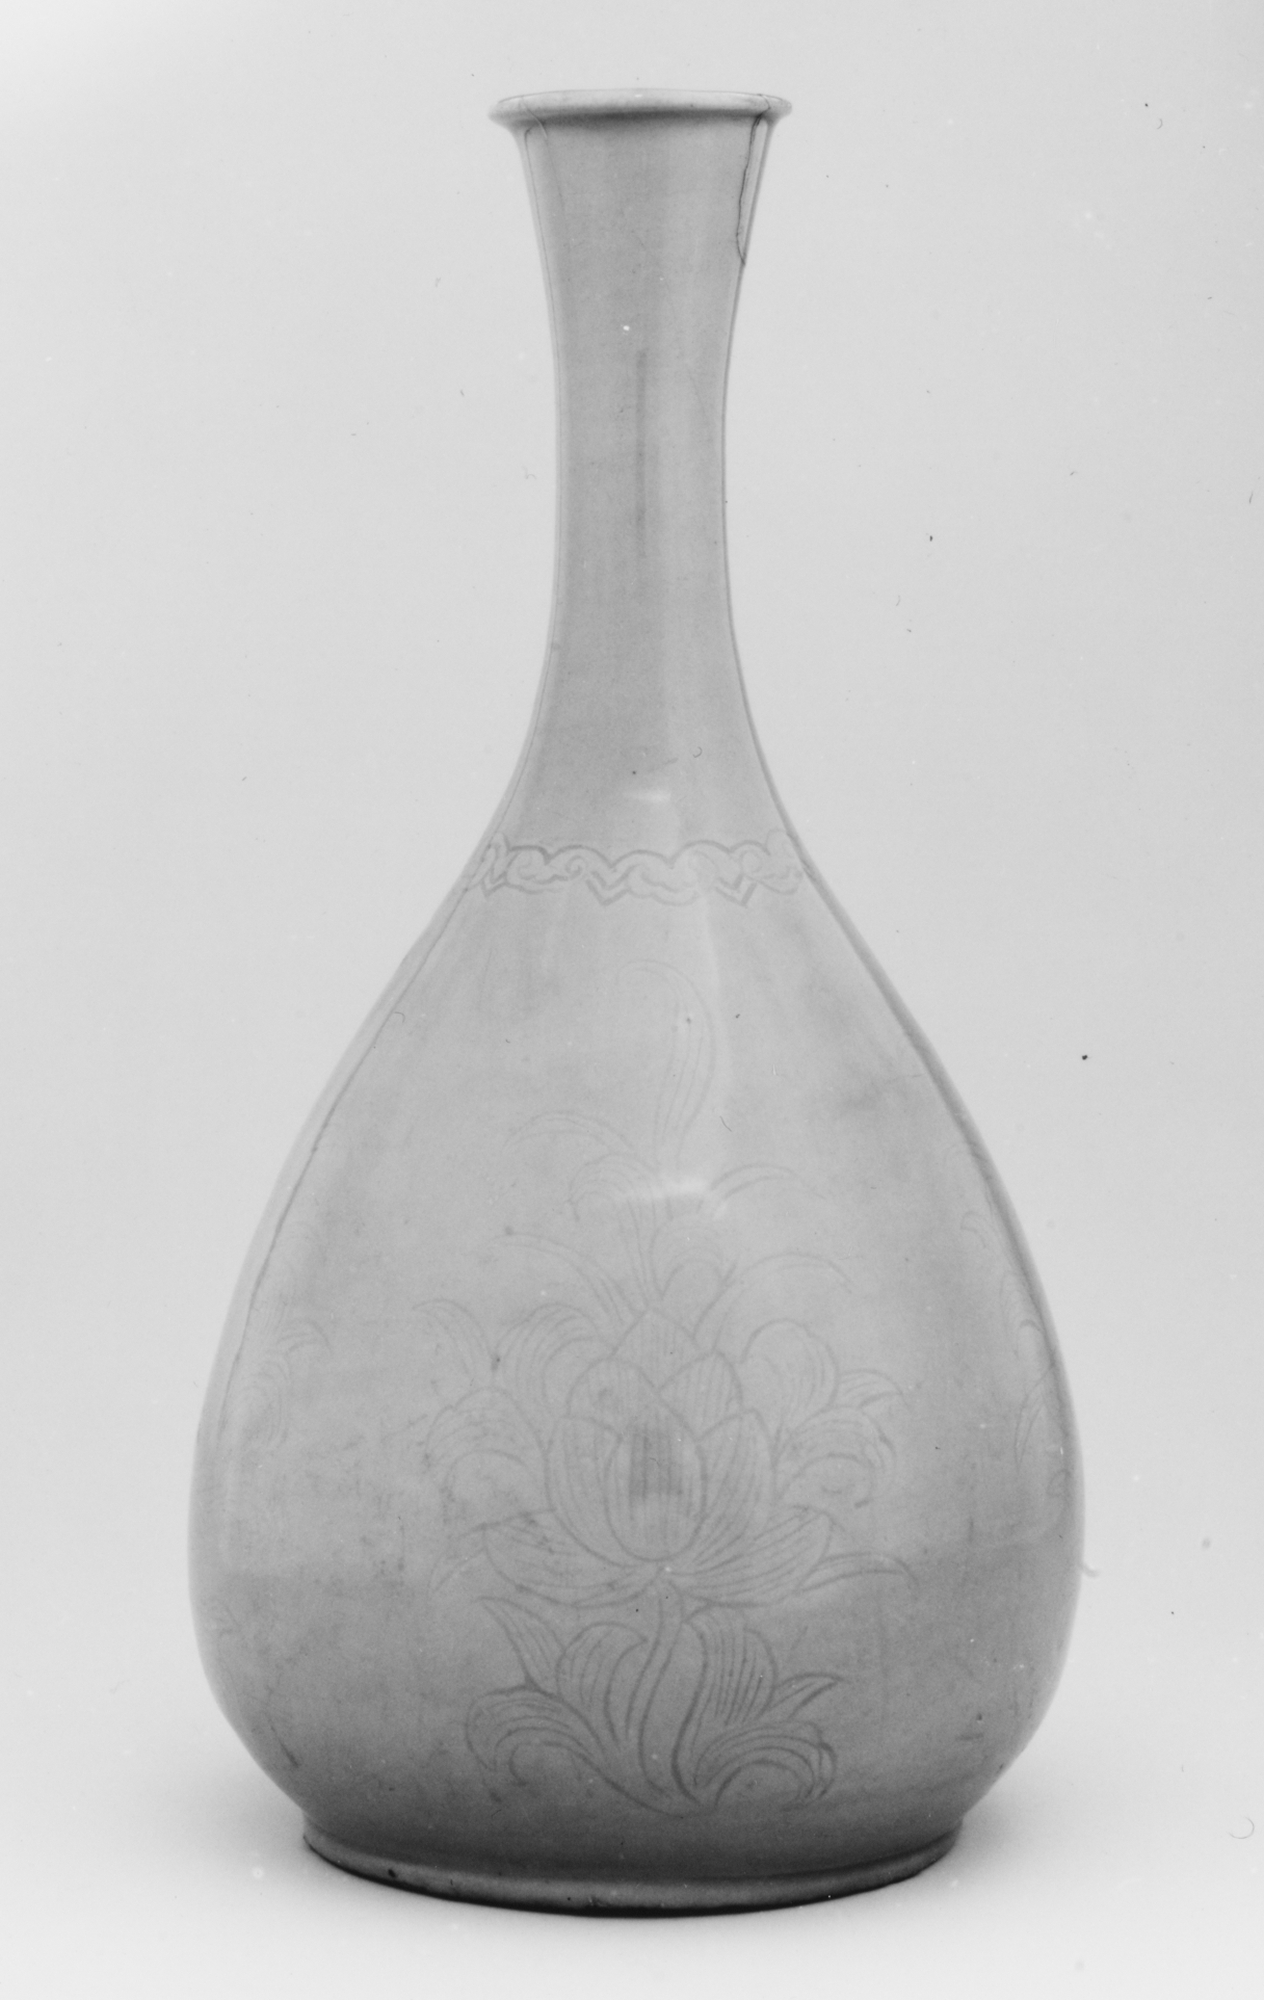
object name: bottle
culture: korean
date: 1101-1133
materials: ceramic glaze, glaze, stoneware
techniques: incising